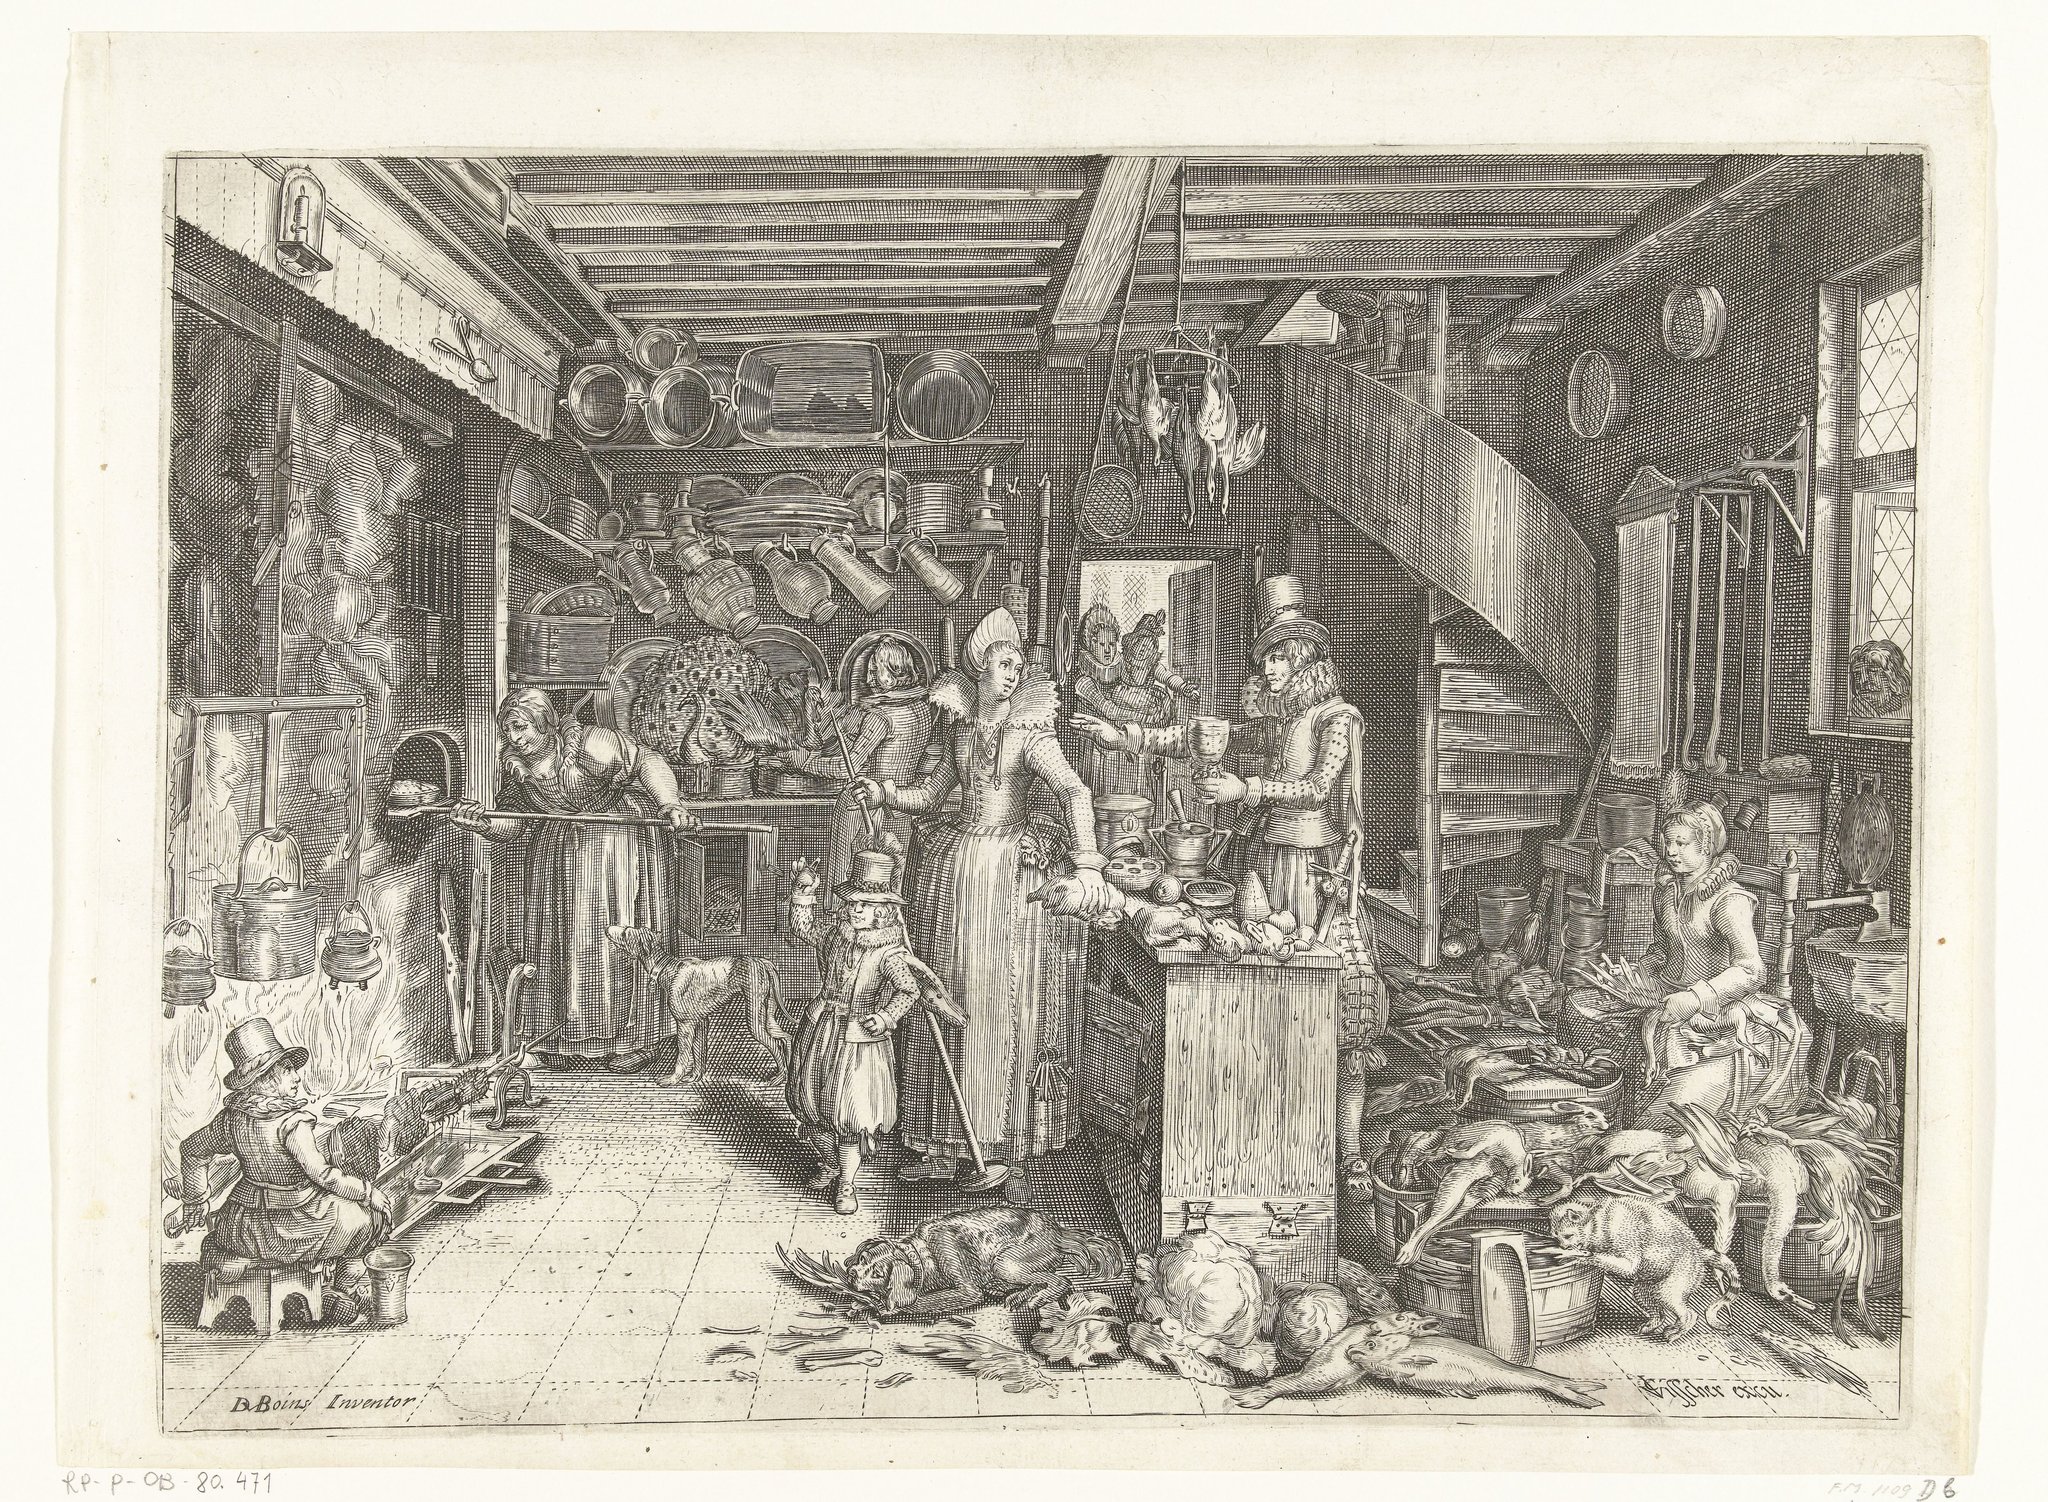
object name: print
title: Keukeninterieur, ca. 1600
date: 1600-1624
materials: paper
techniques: engraving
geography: northern netherlands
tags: kitchen, rich kitchen, low countries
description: Interieur van een volle rijke keuken met de leden van een welgestelde familie. Met veel keukengereedschap en etenswaren: gevogelte, groente, vissen etc. Links het roosteren van gevogelte bij het vuur, een oude vrouw bakt brood. Rechts plukt een keukenmeid een vogel. In het midden een elegant paar.